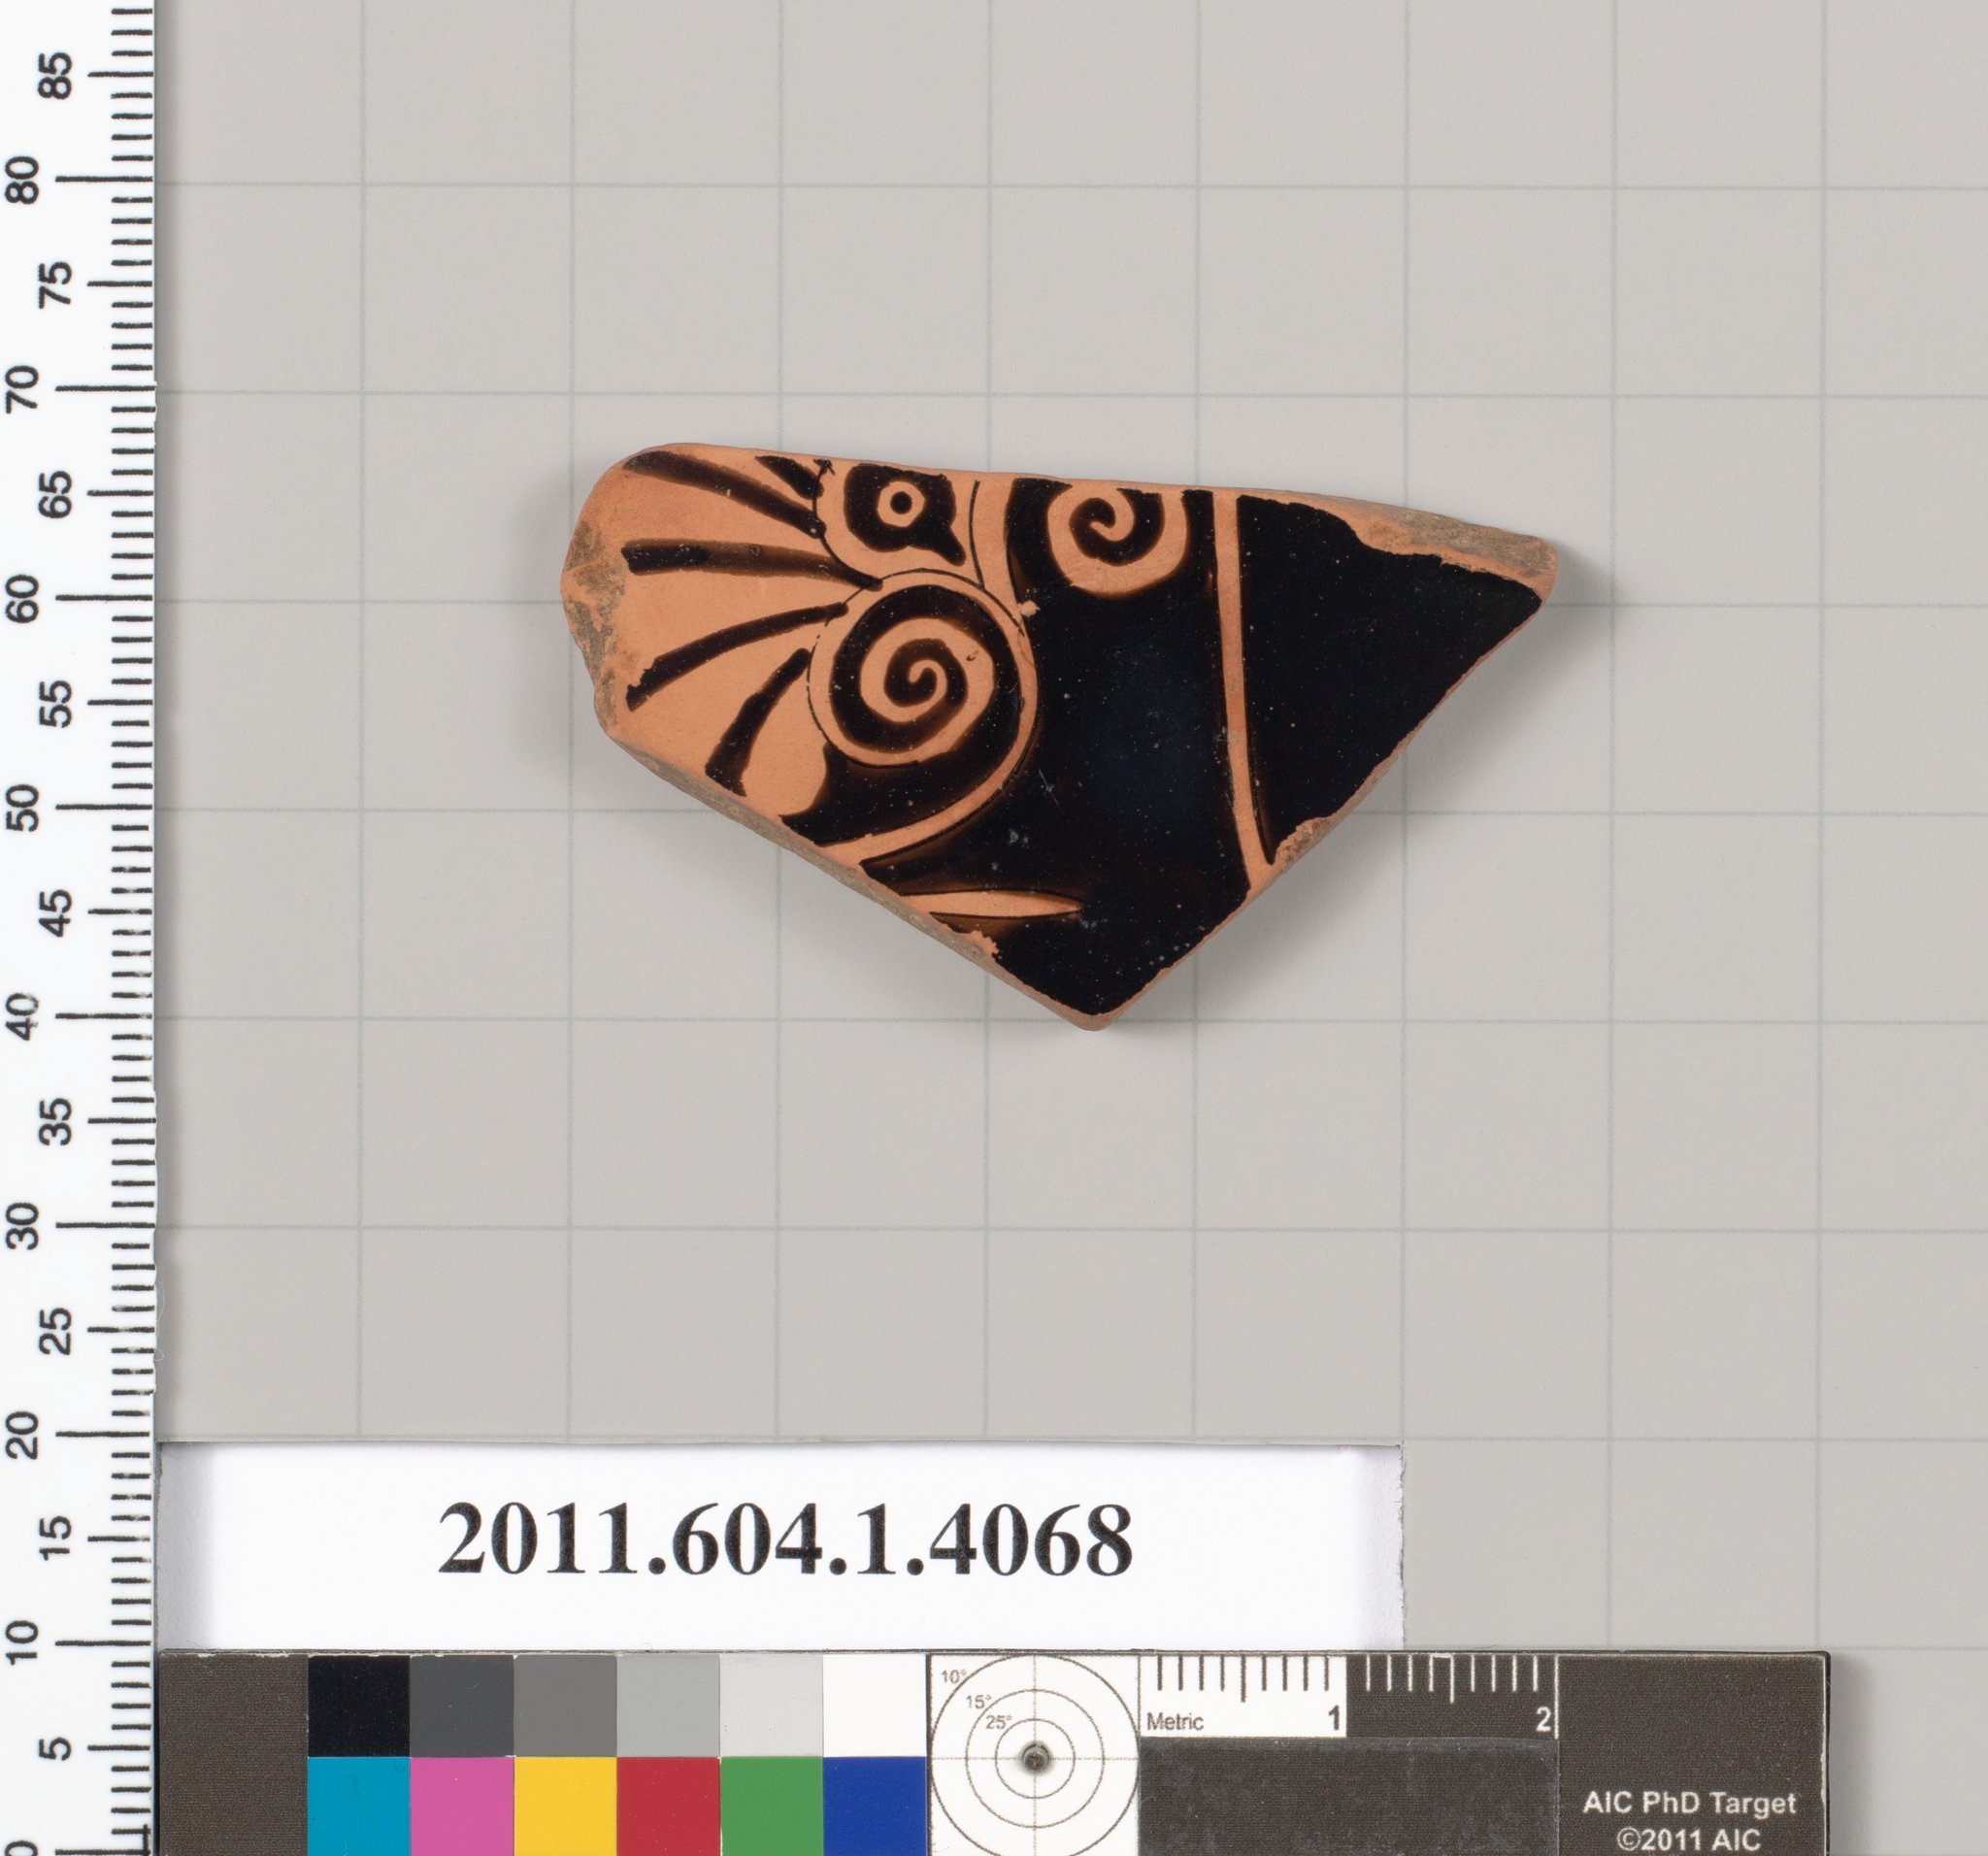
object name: kylix fragment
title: Terracotta fragment of a kylix (drinking cup)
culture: greek, attic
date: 520-500 BCE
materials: terracotta